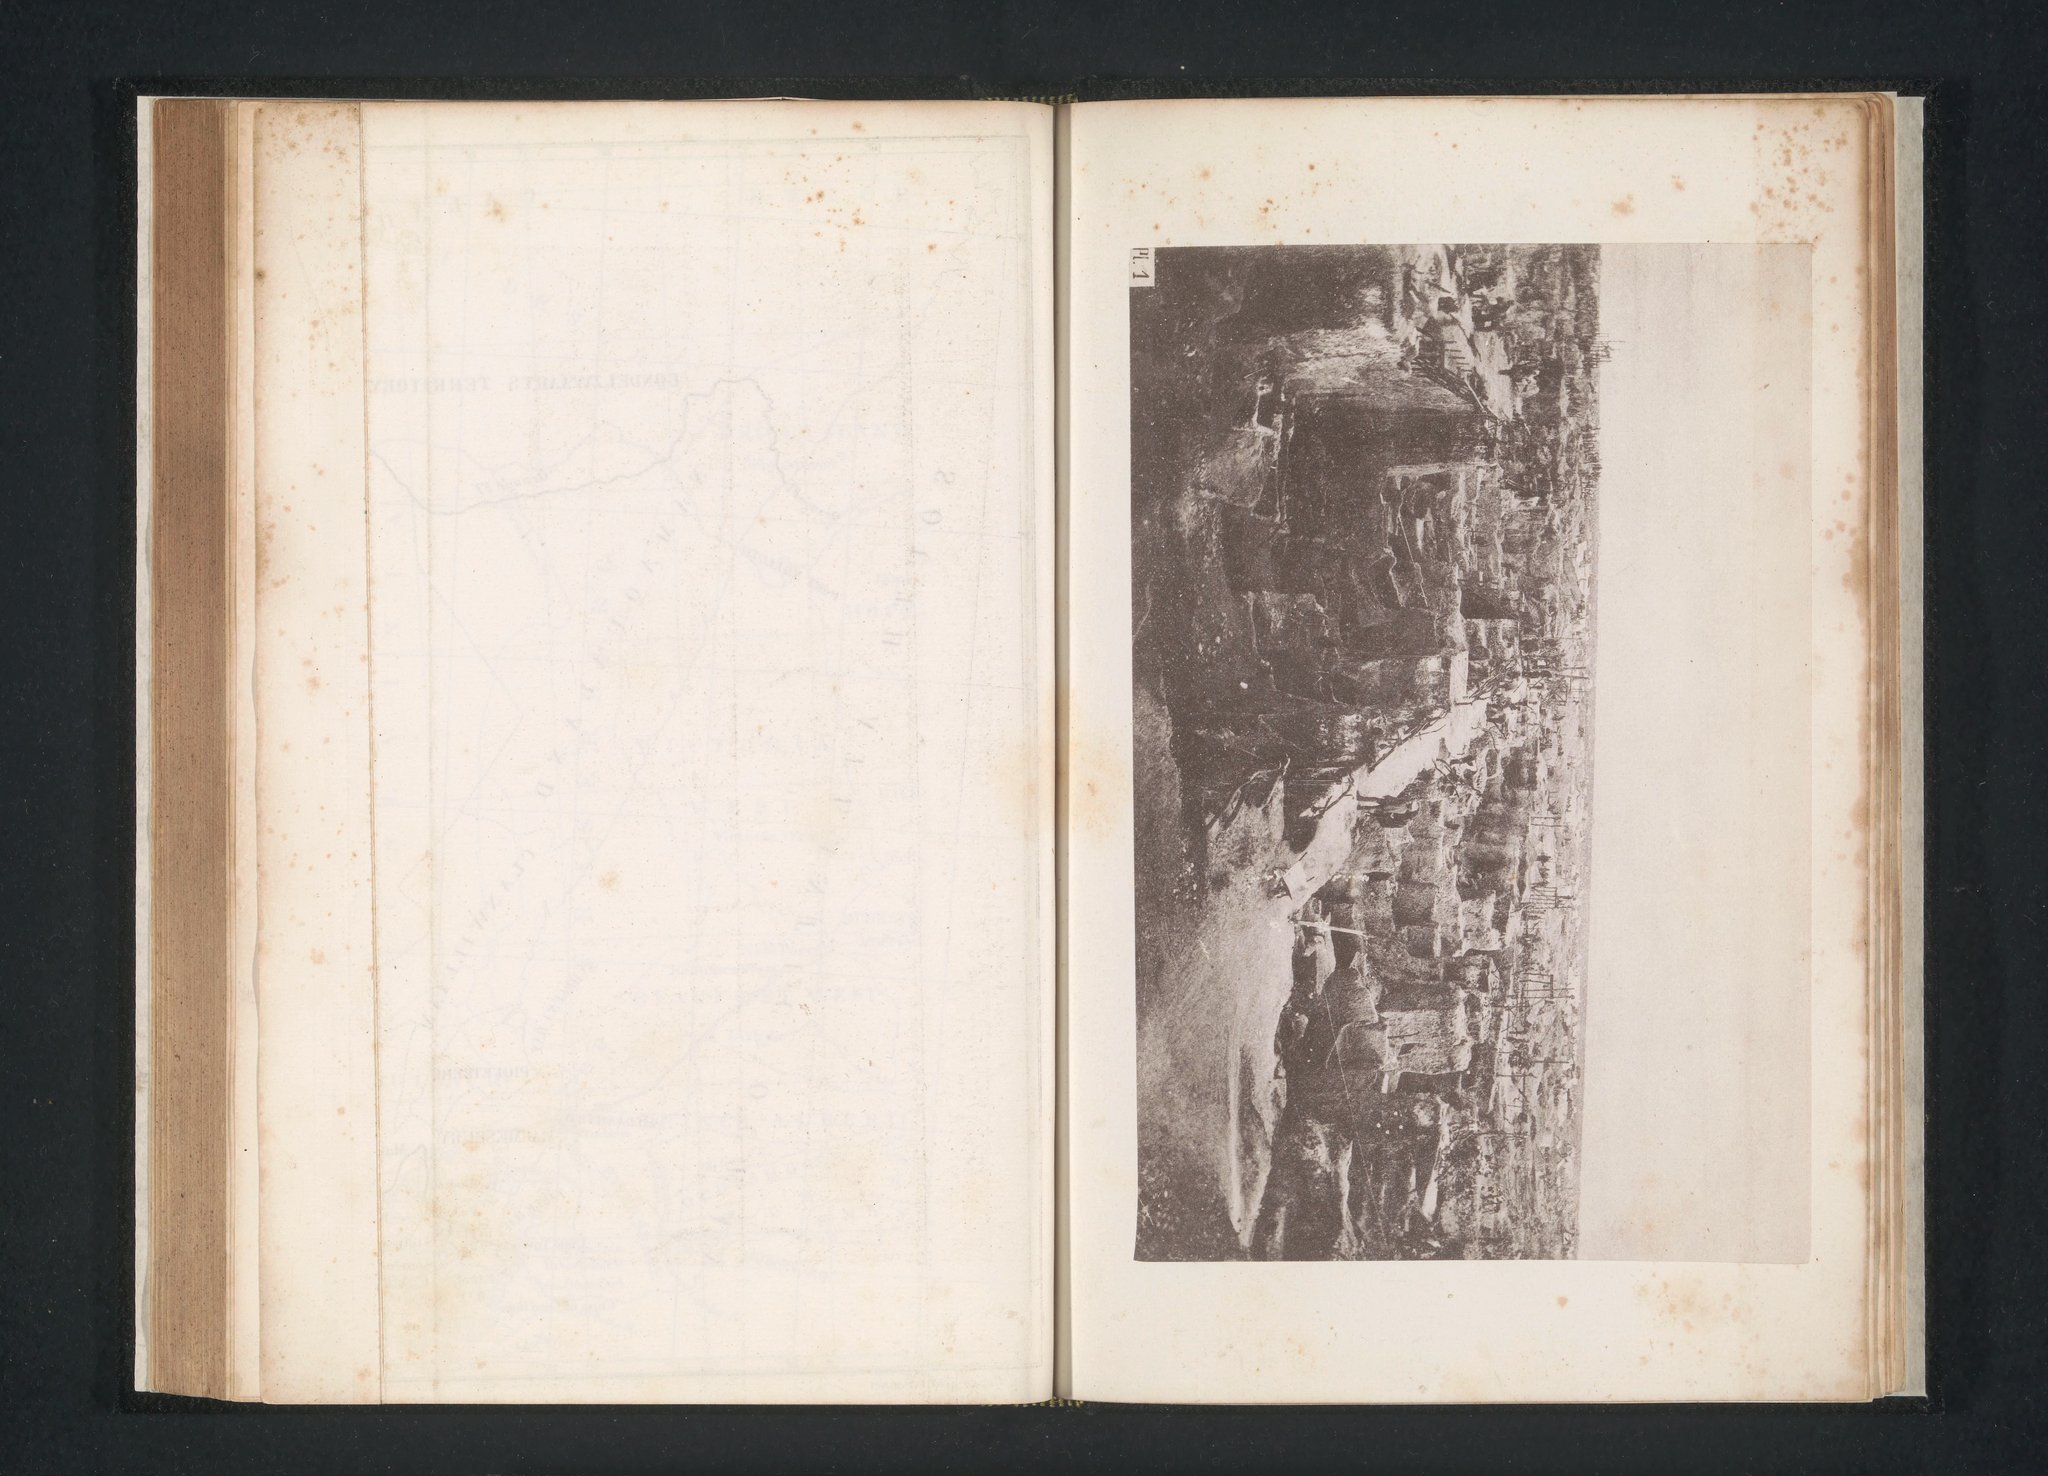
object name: page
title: Gezicht op een diamantmijn in Zuid-Afrika, vermoedelijk bij Kimberley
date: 1870-1880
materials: paper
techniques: photograph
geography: south africa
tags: mine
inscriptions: number: ‘Pl. 1’